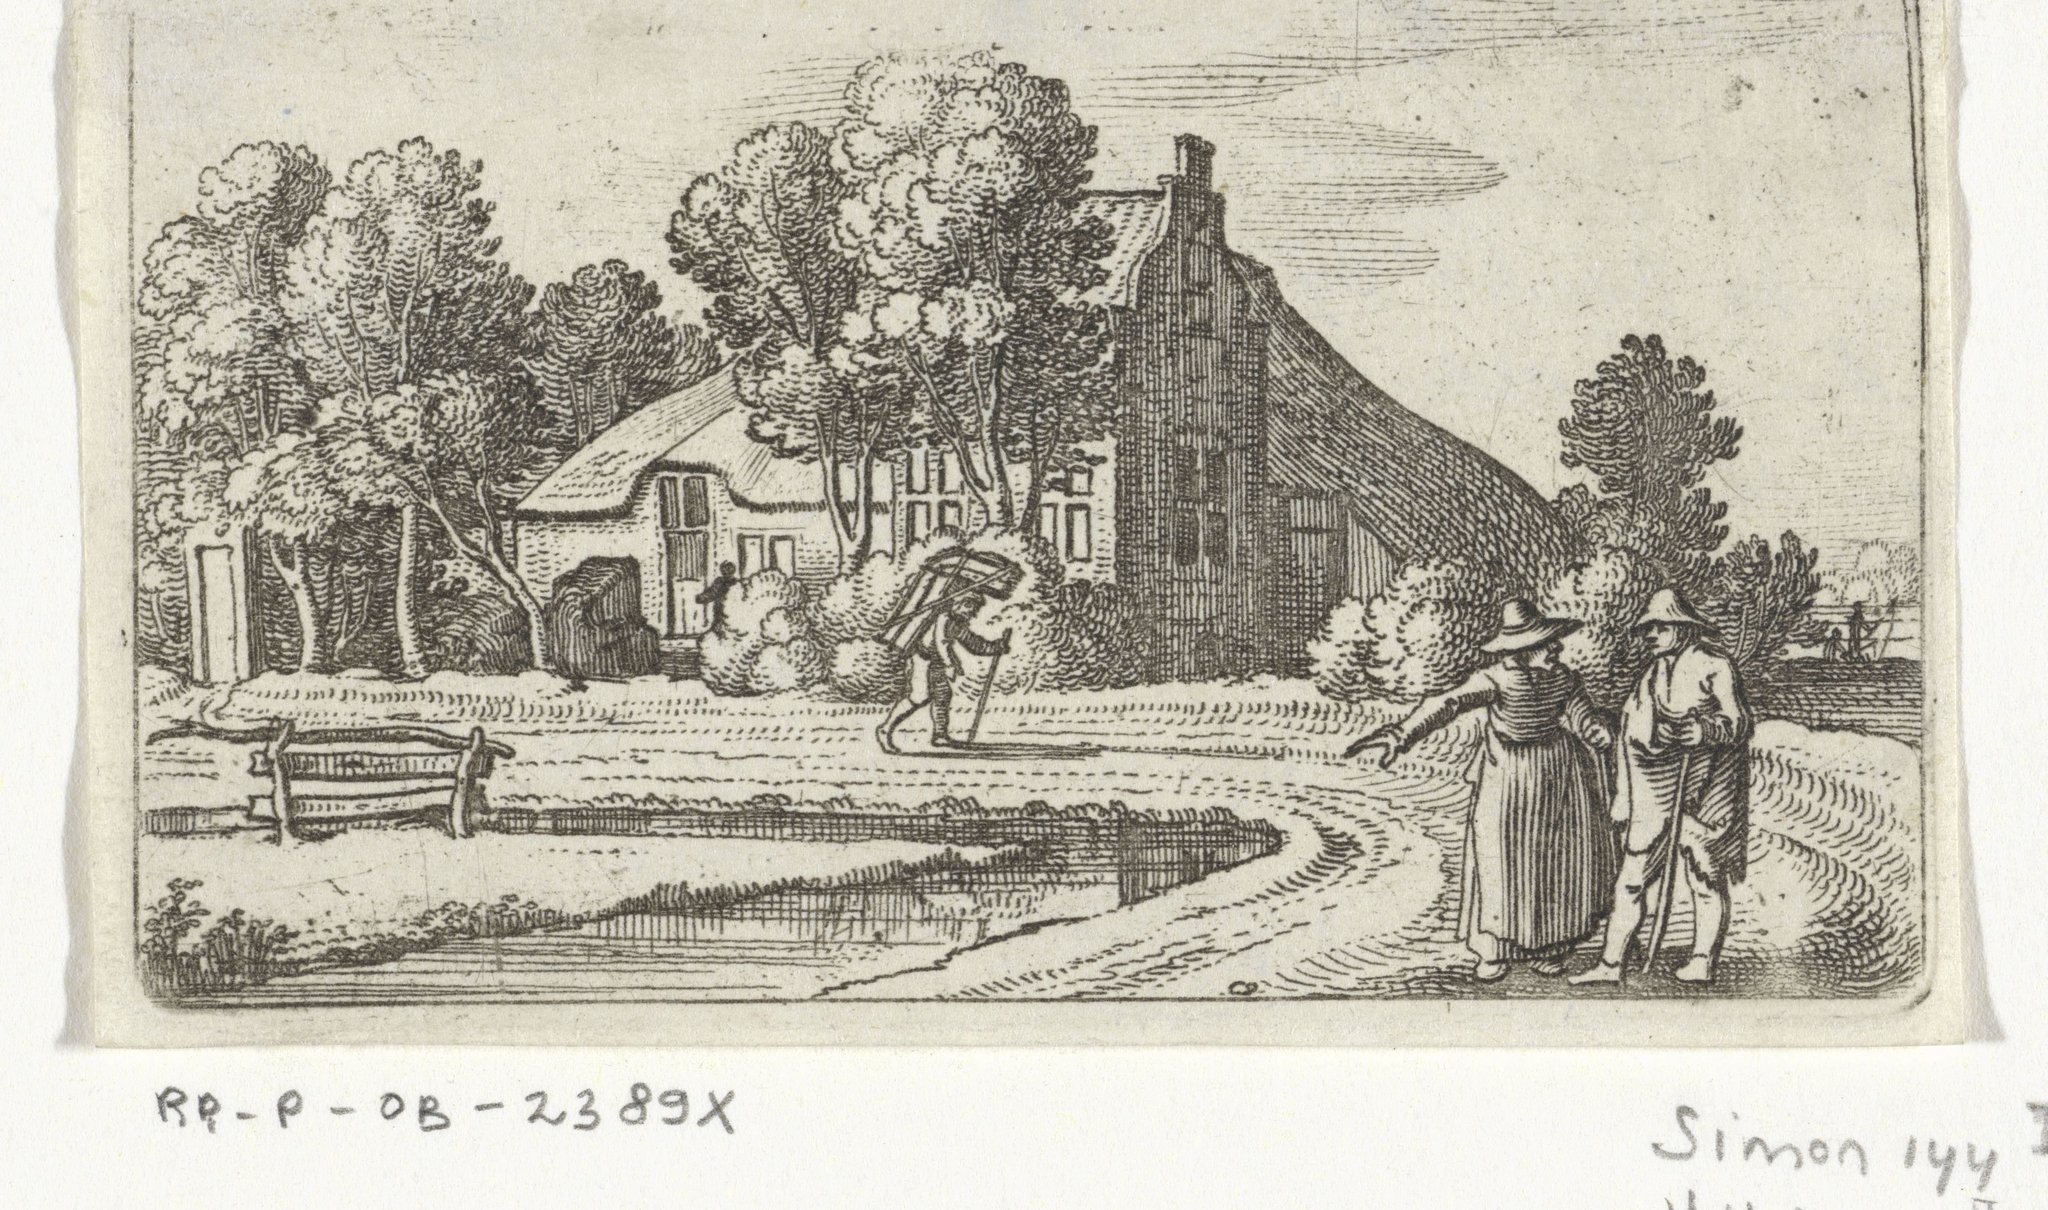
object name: print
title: Landweg bij Amstelveen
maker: claes jansz. visscher (ii)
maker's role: draughtsman, print maker, publisher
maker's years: 1586-1652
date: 1612-1652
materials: paper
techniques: etching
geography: amsterdam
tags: road, path, farm or solitary house in landscape, index finger forwards, pointing, indicating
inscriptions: collector's mark: Lugt 2228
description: Gezicht op een bocht in een landweg bij Amstelveen. Aan de kromming van de weg ligt een boerderij, waar een zwaar bepakte man voorbij loopt. Op de voorgrond een man en een vrouw in gesprek.